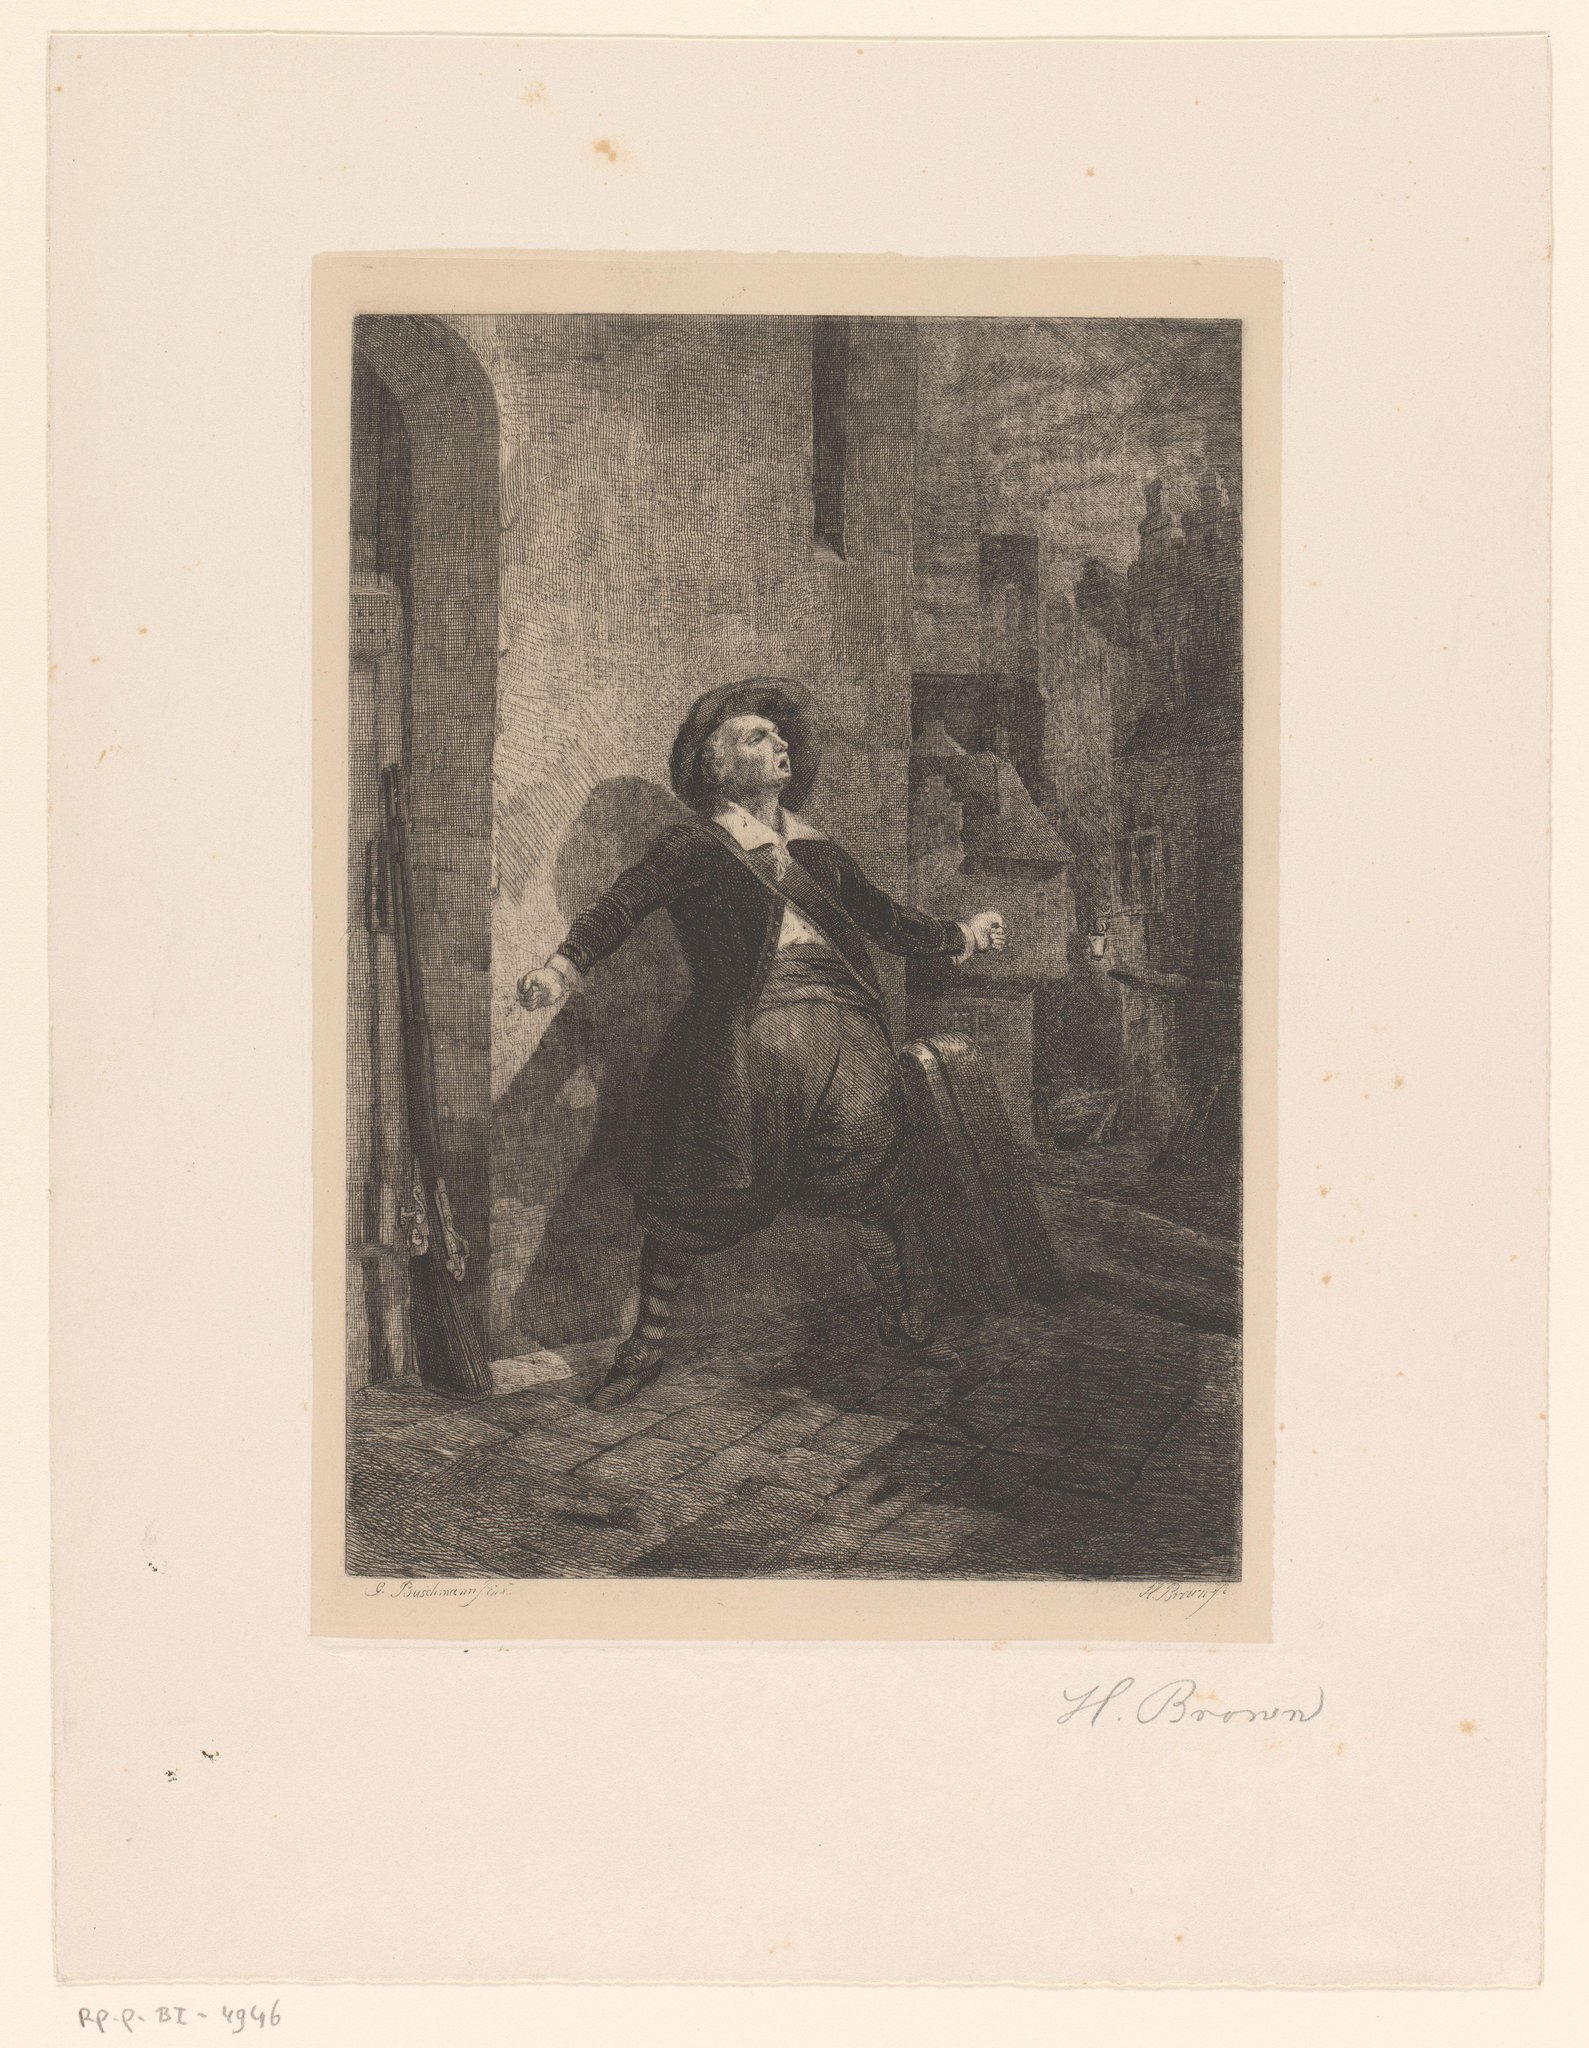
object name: print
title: Man op straat met een geweer naast zich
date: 1826-1870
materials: paper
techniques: etching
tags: adult man, firearms: rifle, street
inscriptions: collector's mark: Lugt 2228